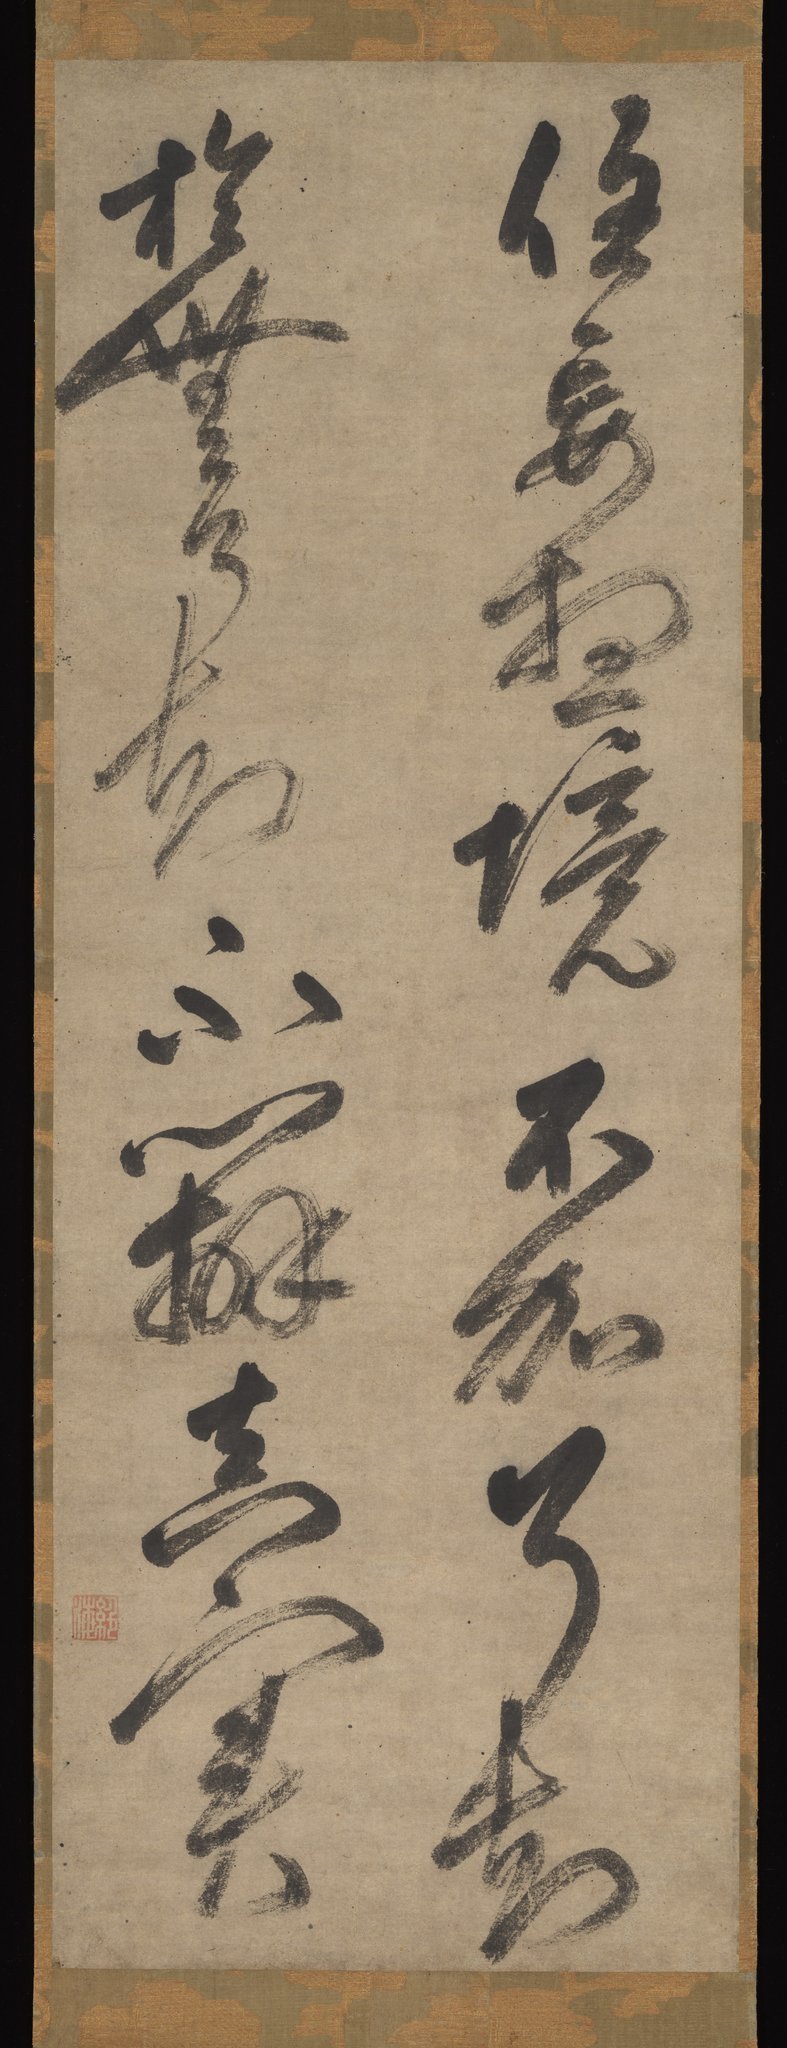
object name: hanging scroll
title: Sacred Verse (Gāthā) from the Sutra of Perfect Enlightenment (Engaku-kyō)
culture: japanese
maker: zekkai chūshin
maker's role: artist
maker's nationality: japanese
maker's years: 1336-1405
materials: ink, paper